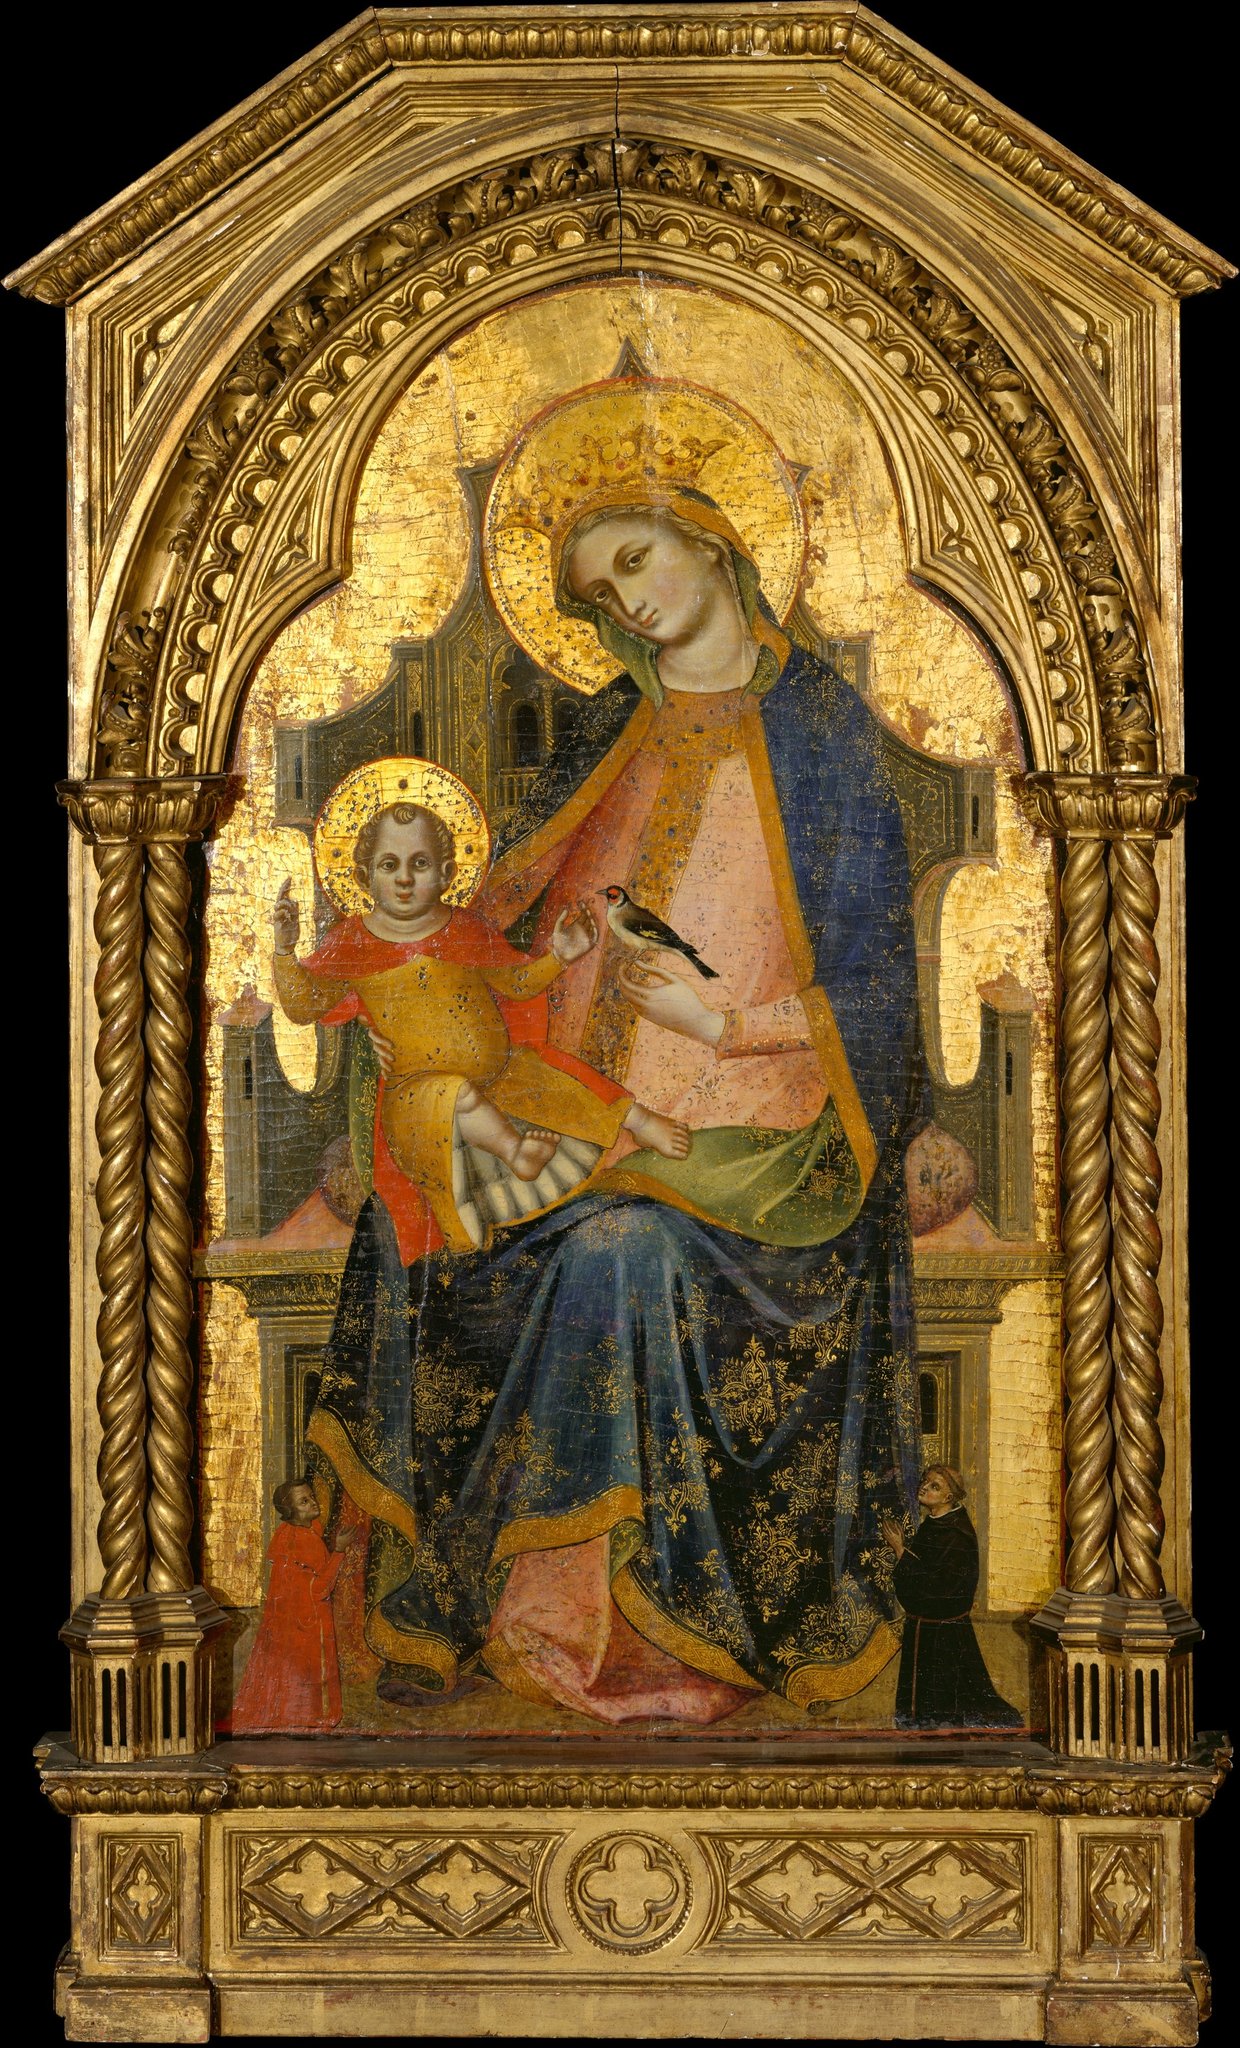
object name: painting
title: Madonna and Child Enthroned with Two Donors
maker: lorenzo veneziano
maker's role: artist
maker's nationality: italian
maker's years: 1356-1372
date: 1360-1365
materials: gold leaf, paint, wood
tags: birds,men,madonna and child